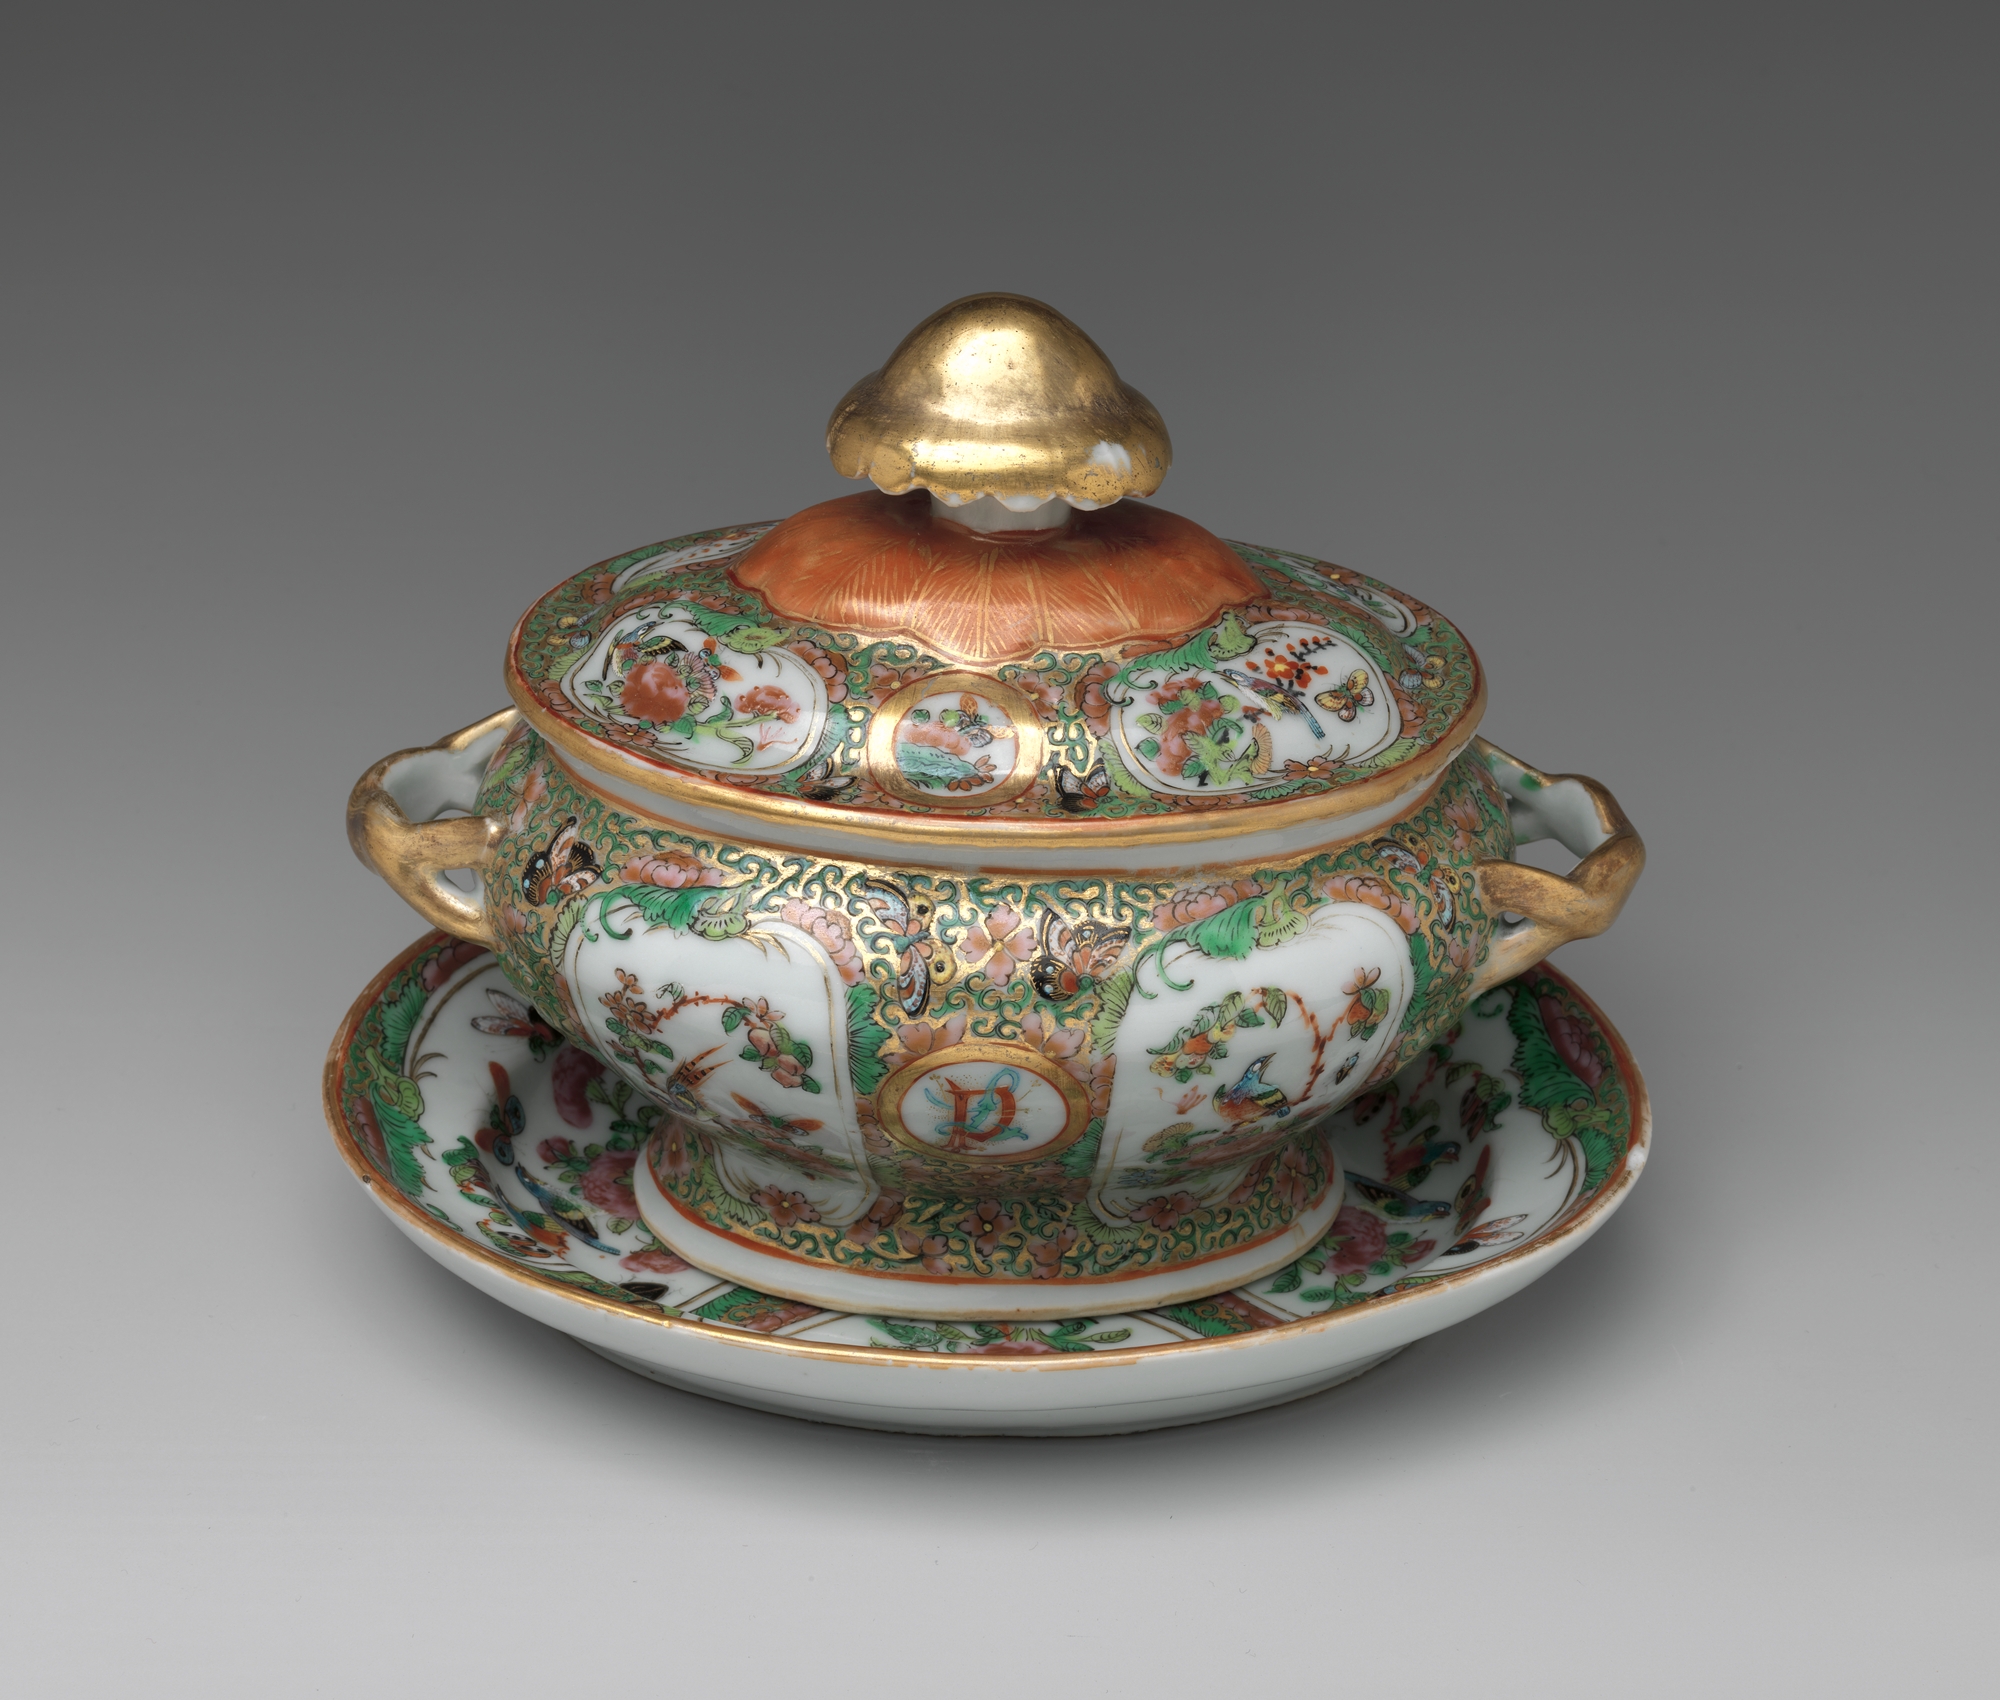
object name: sauceboat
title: Covered Sauceboat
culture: chinese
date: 1860-1866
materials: porcelain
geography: china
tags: flowers